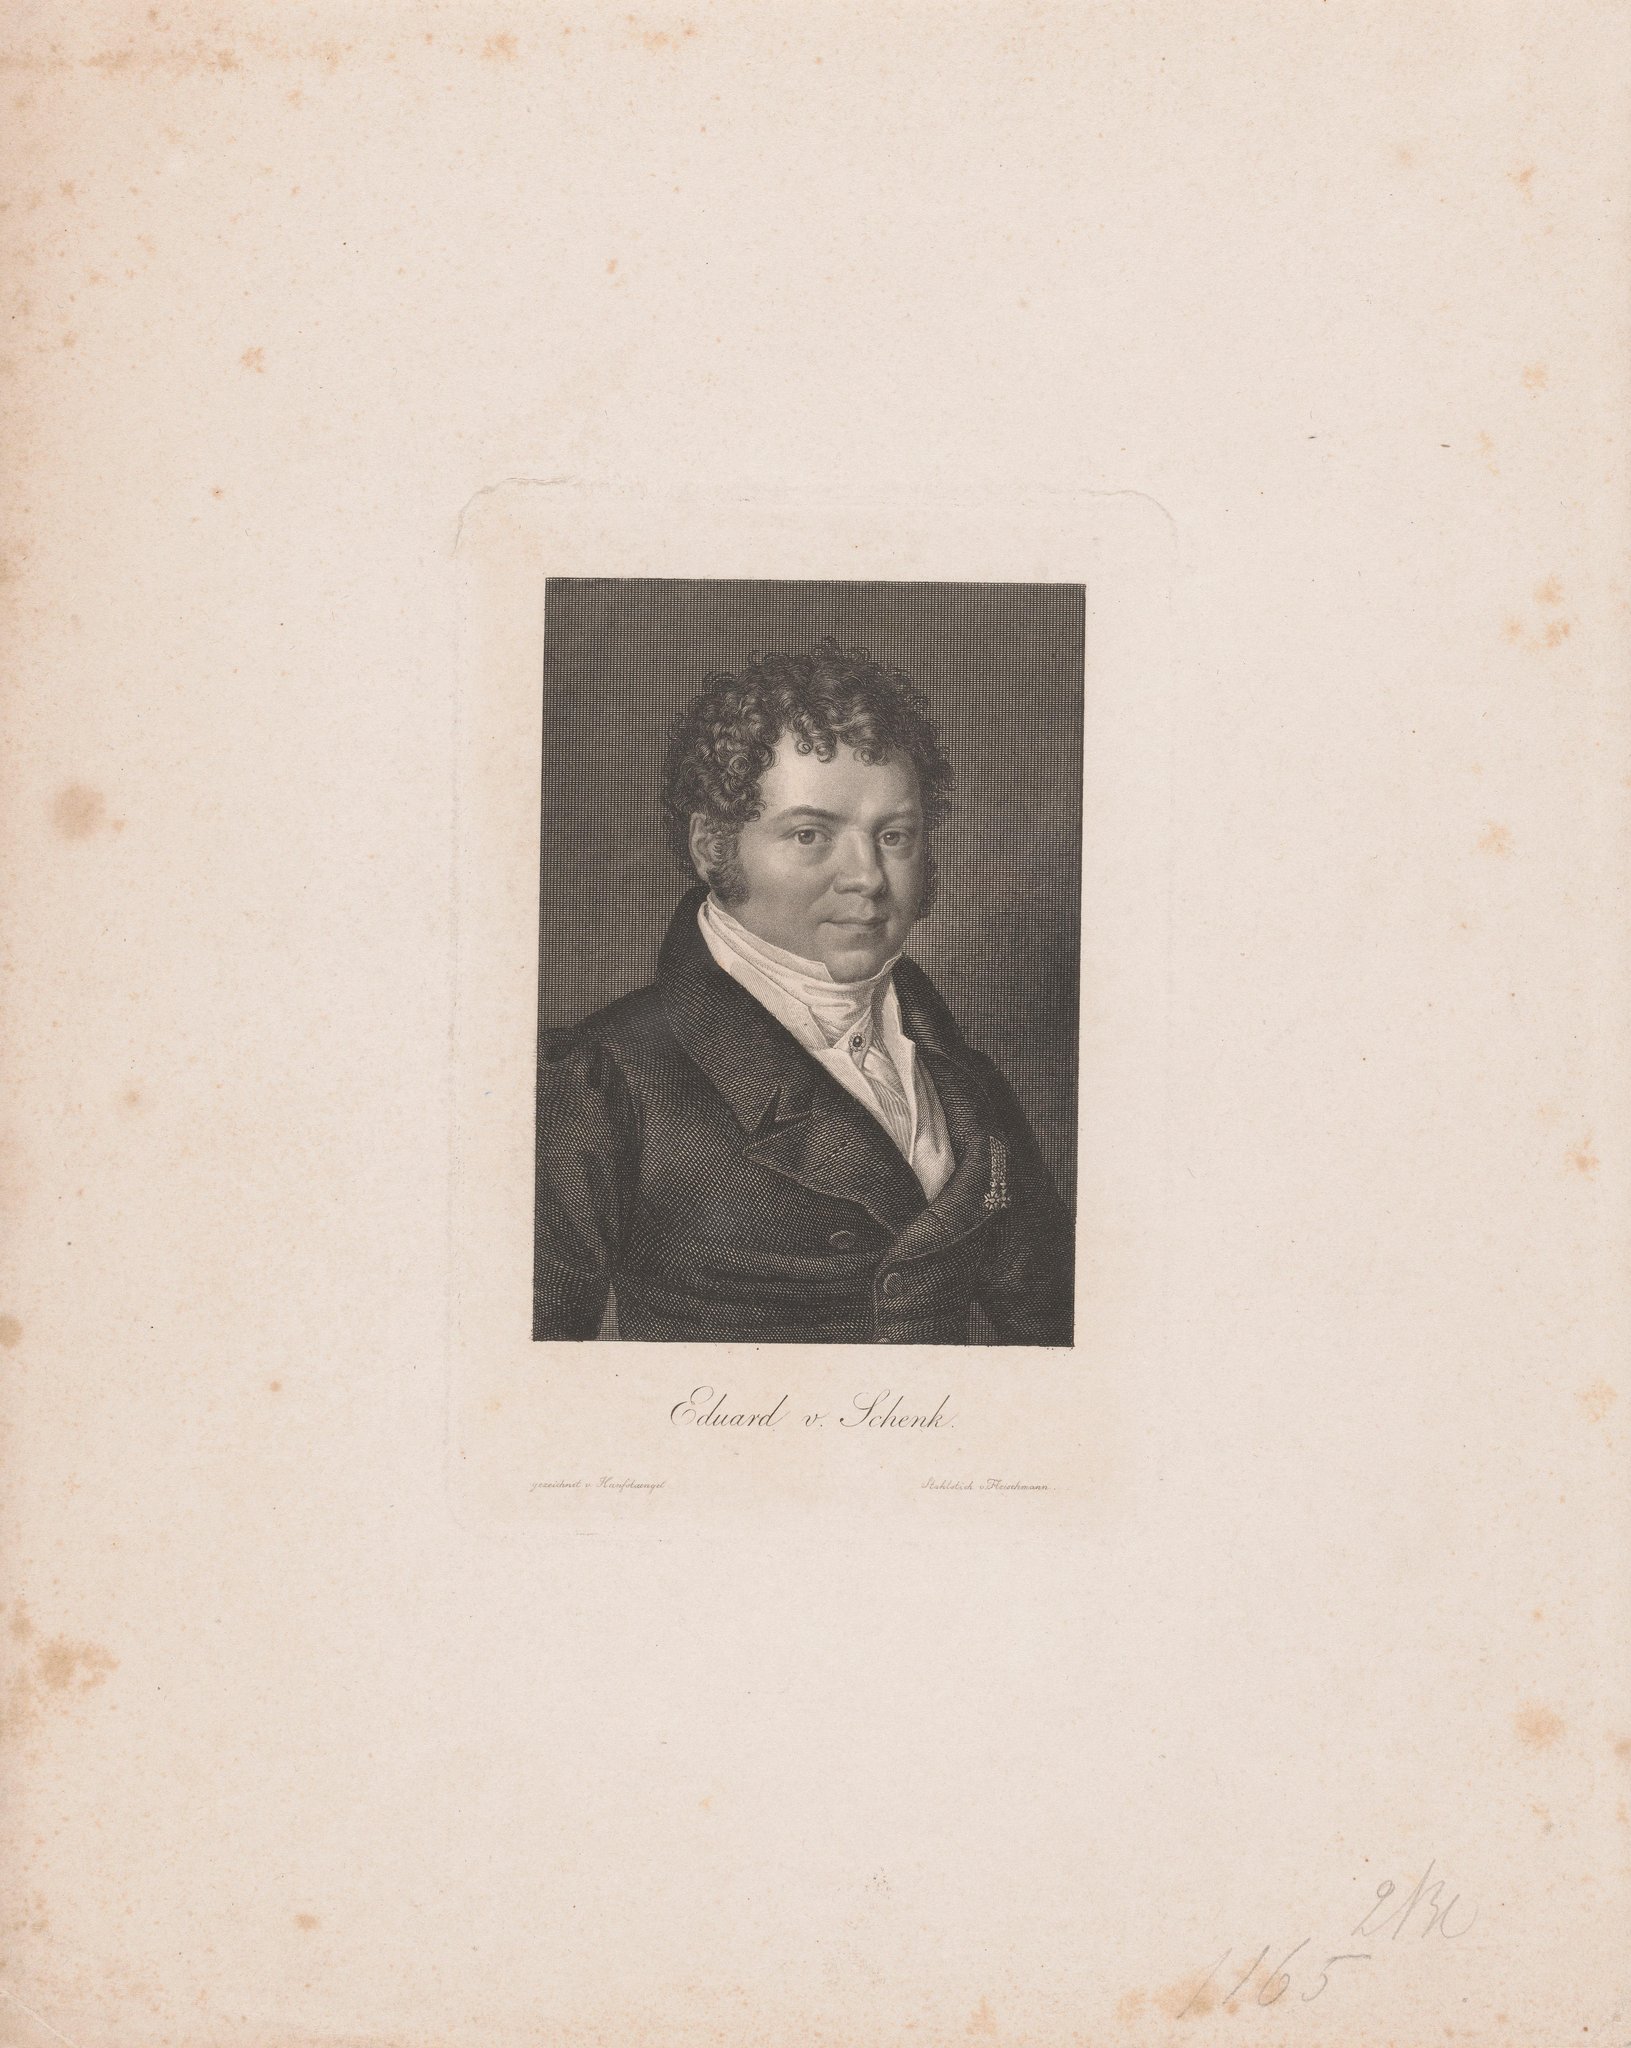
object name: print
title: Portret van Eduard von Schenk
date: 1801-1834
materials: paper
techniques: engraving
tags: historical persons, portrait of a writer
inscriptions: collector's mark: Lugt 2228